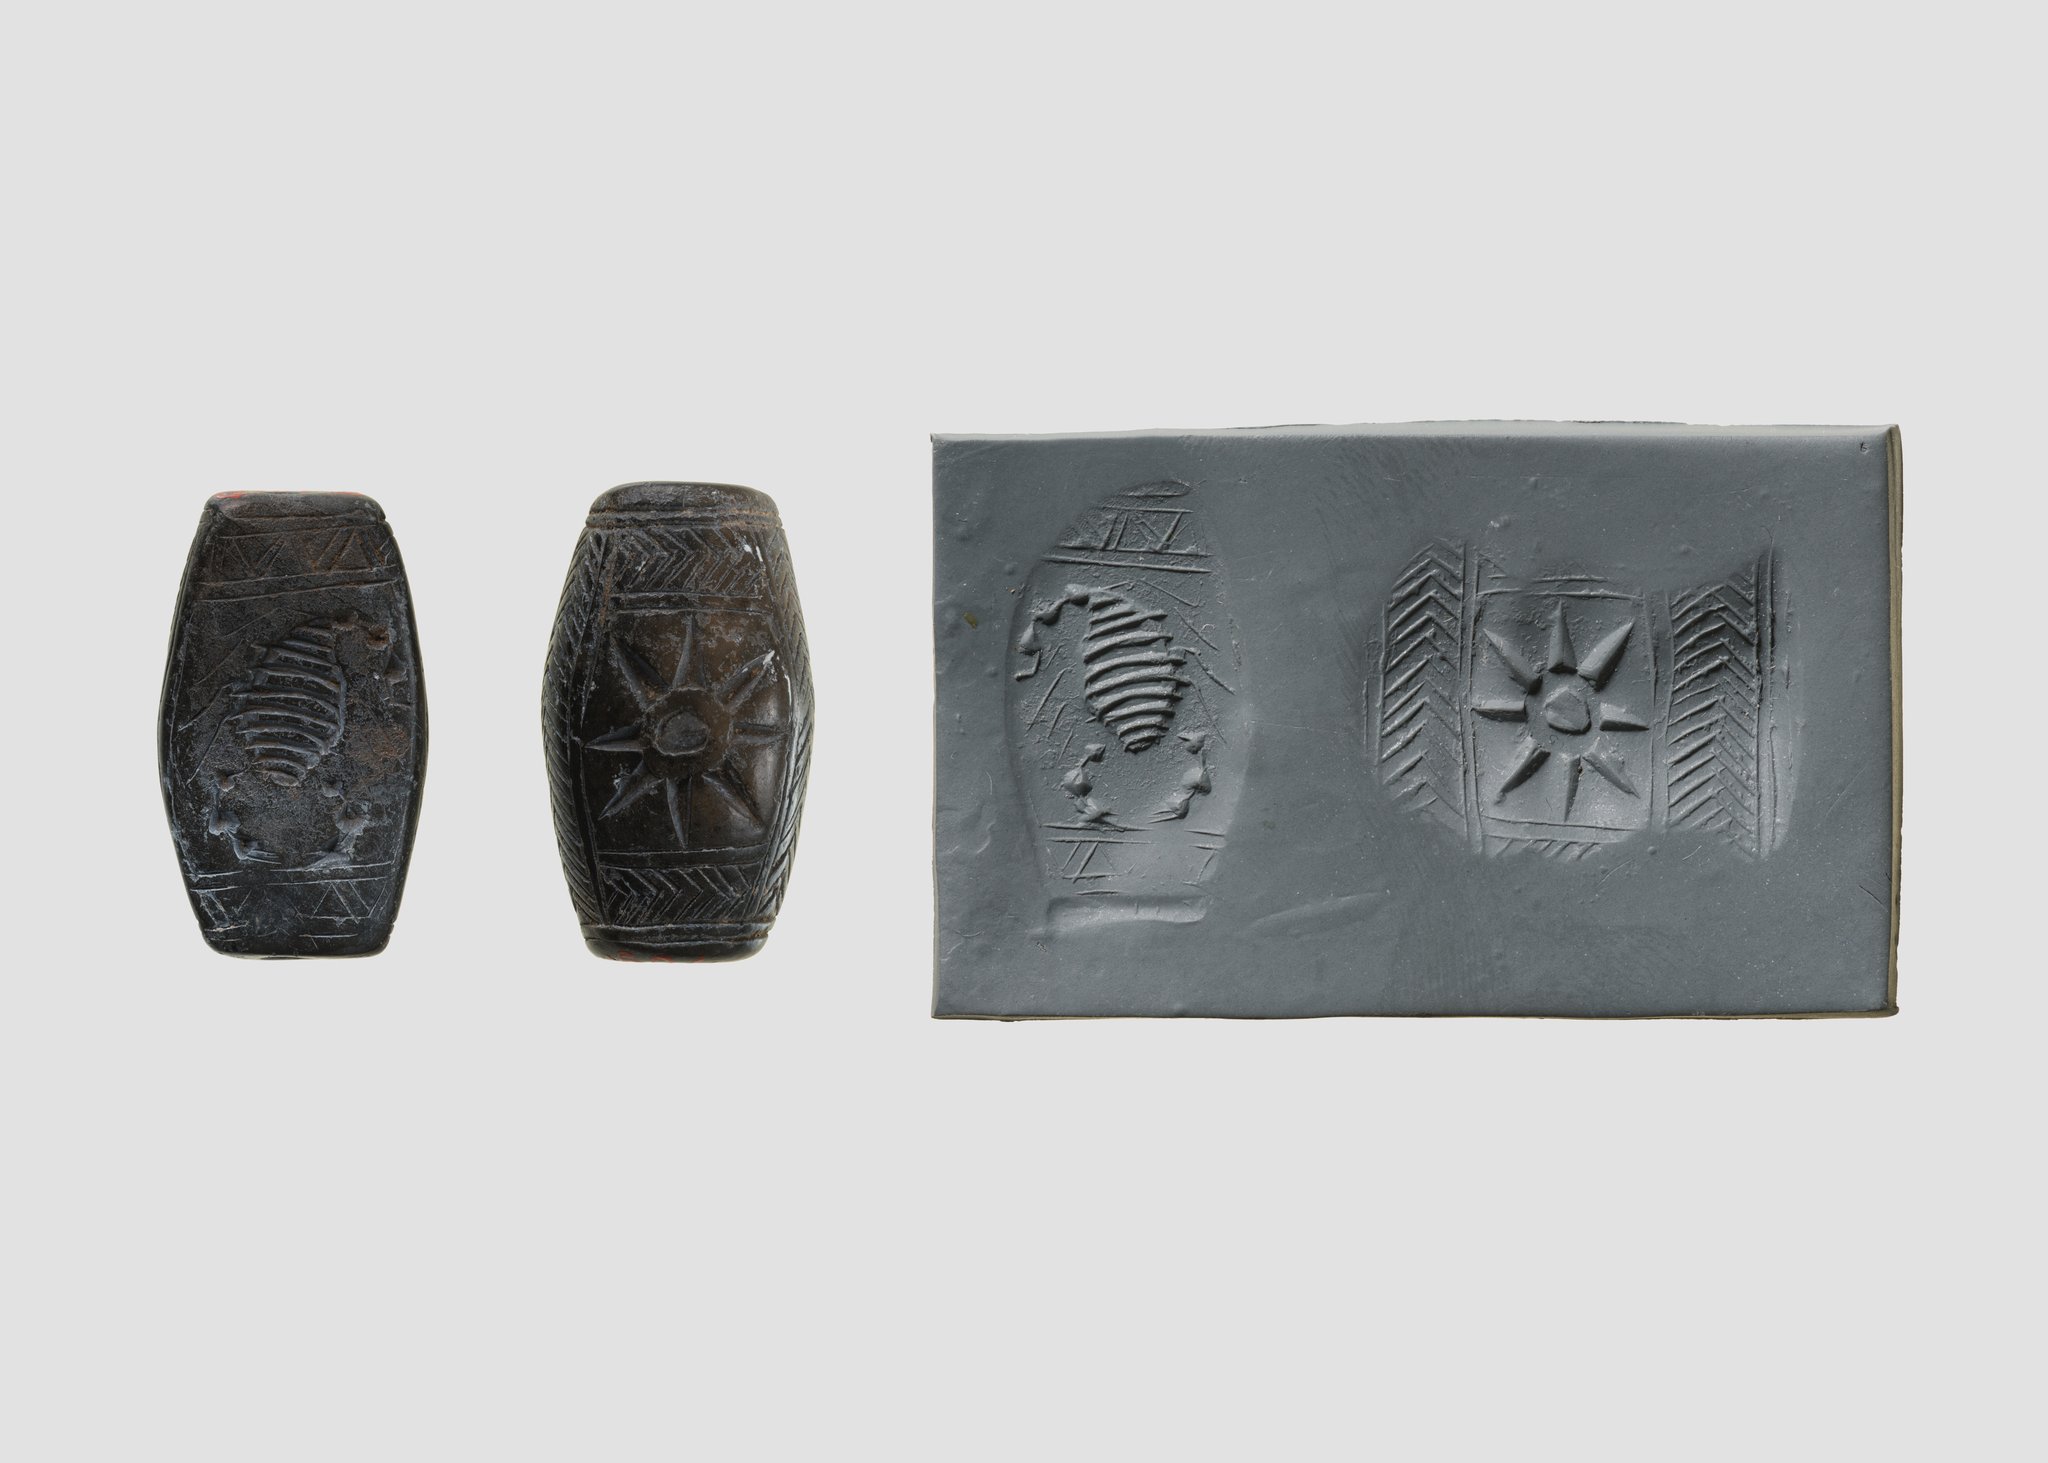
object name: stamp seal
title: Stamp seal (loaf-shaped hemispheroid) with animal and symbol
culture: assyrian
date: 900-701 BCE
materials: limestone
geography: iran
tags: scorpions